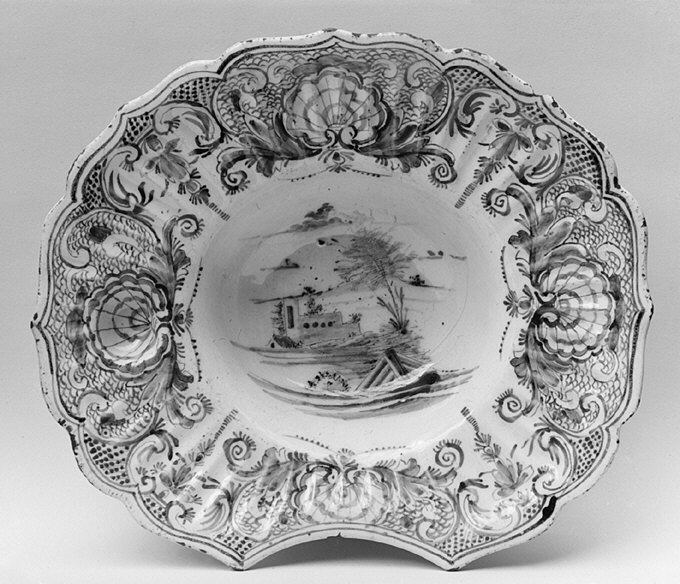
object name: barber's basin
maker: de witte starre manufactory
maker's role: maker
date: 1734-1766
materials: earthenware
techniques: glazing